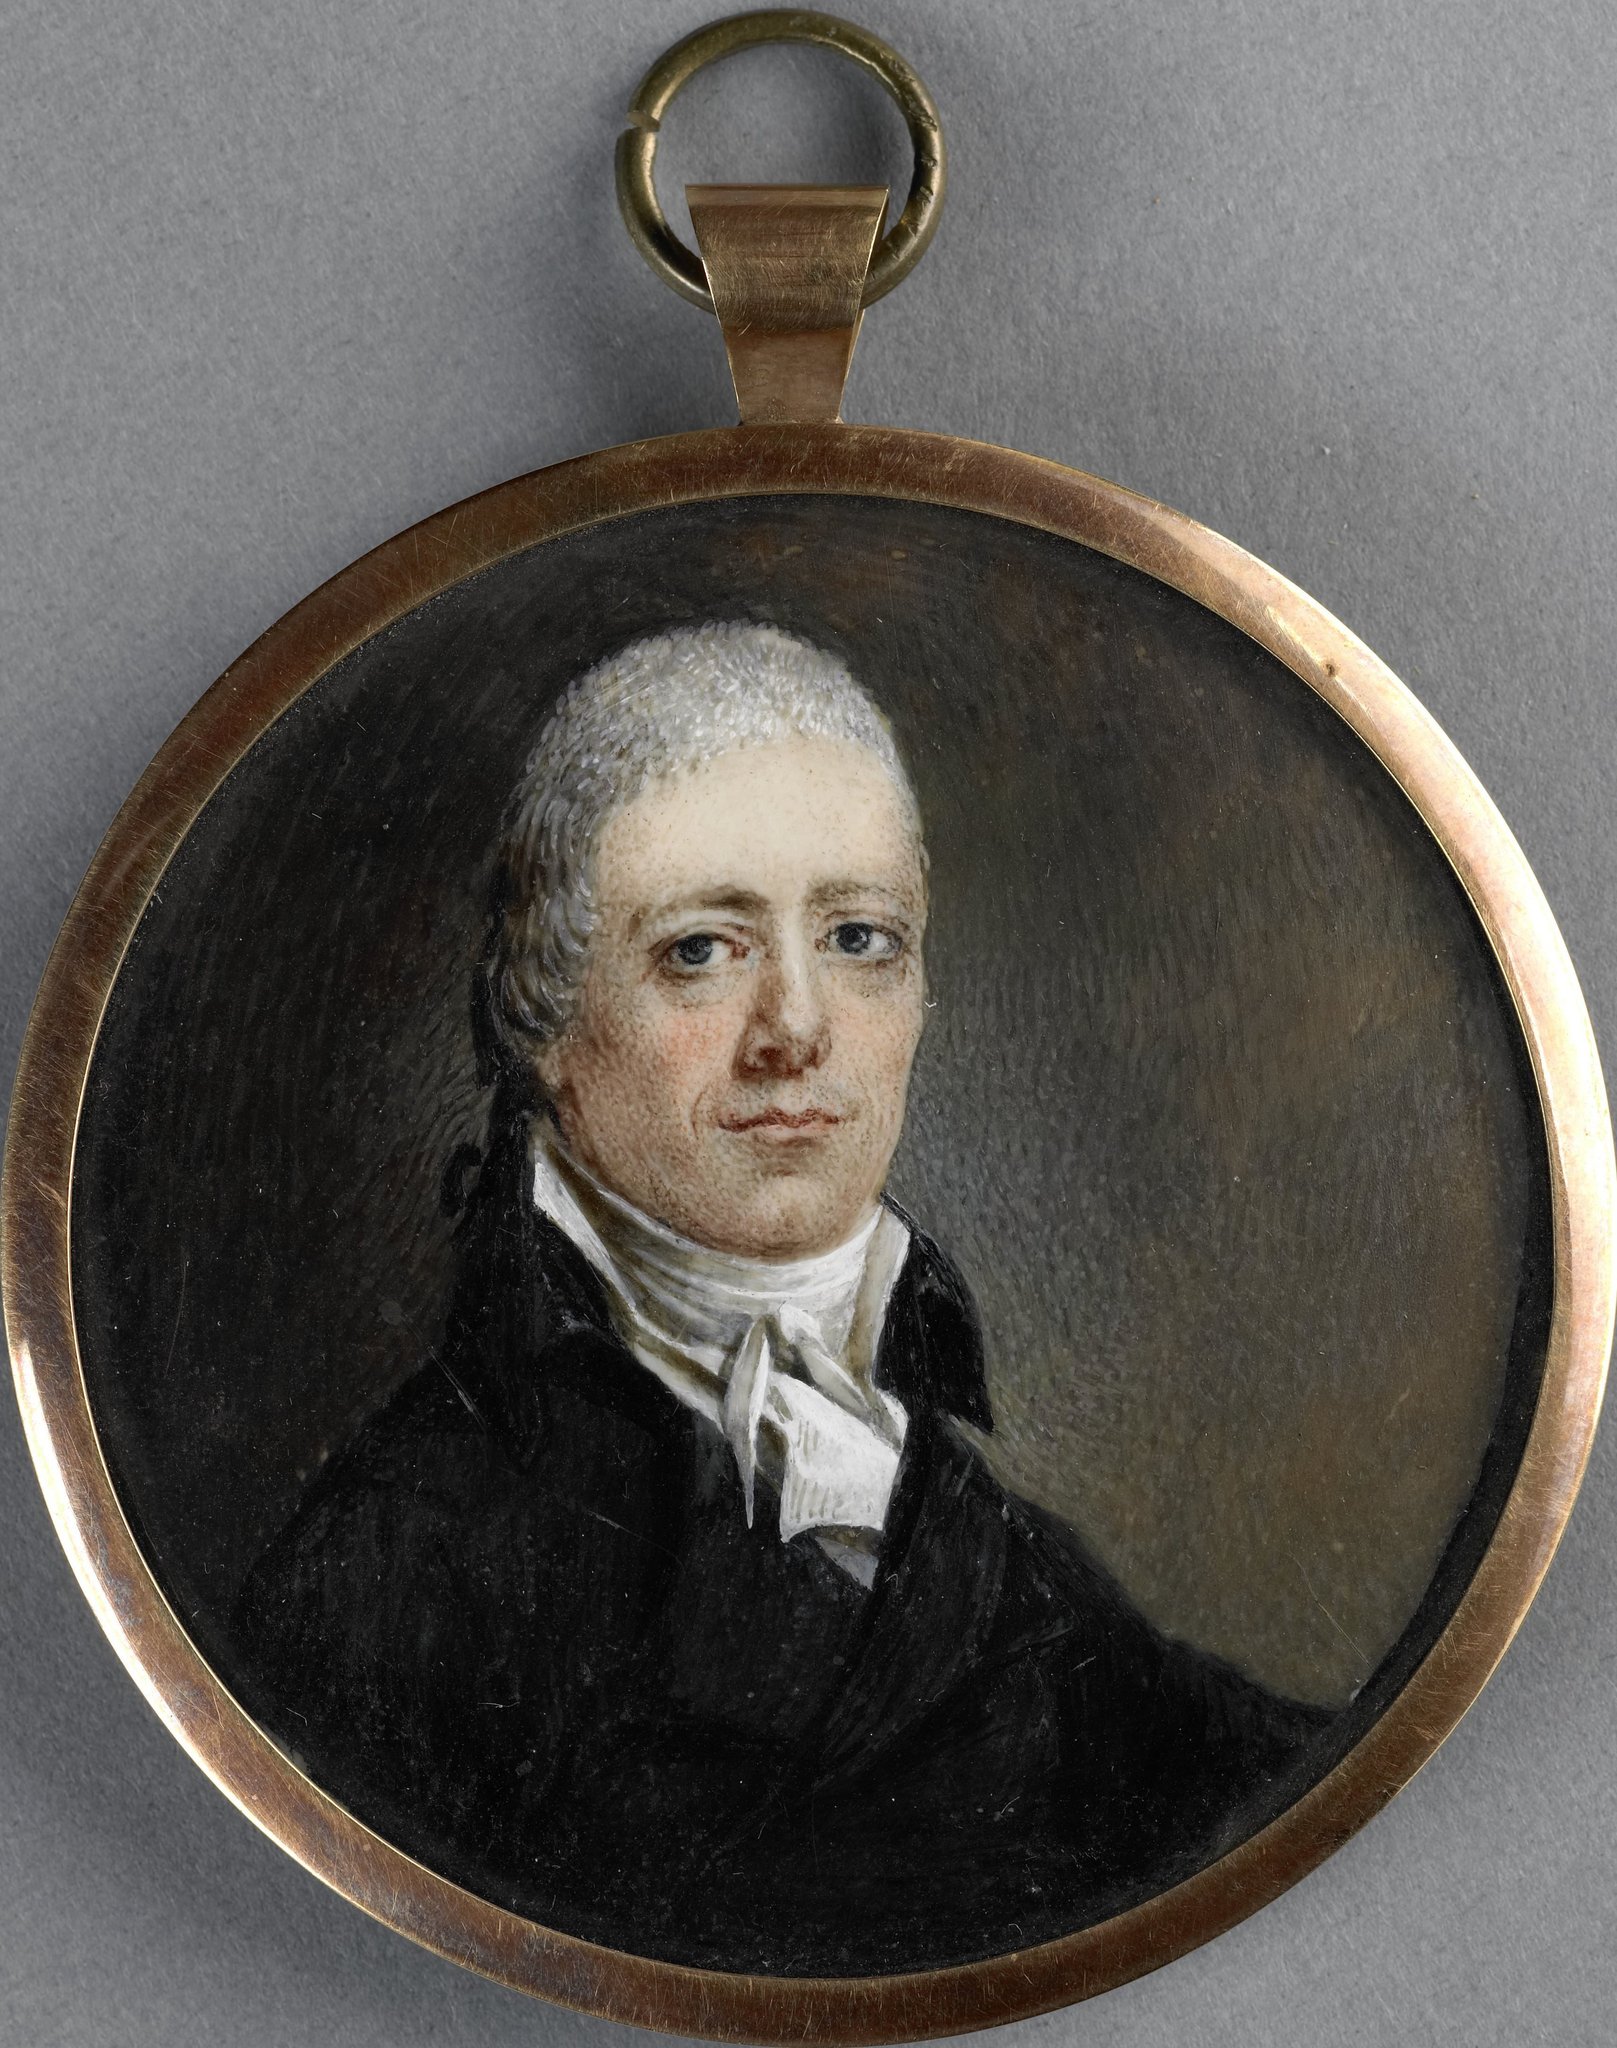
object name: painting, miniature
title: Portret van een man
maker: Anonymous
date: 1805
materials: glass, hair, ivory, metal, oil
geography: northern netherlands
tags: historical persons not known by name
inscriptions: inscription: ‘JL [in monogram]’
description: Portrait of a man. Northern Netherlands school. Ivory, c. 1805. Formed part of an unclaimed estate, Paramaribo, 1912.